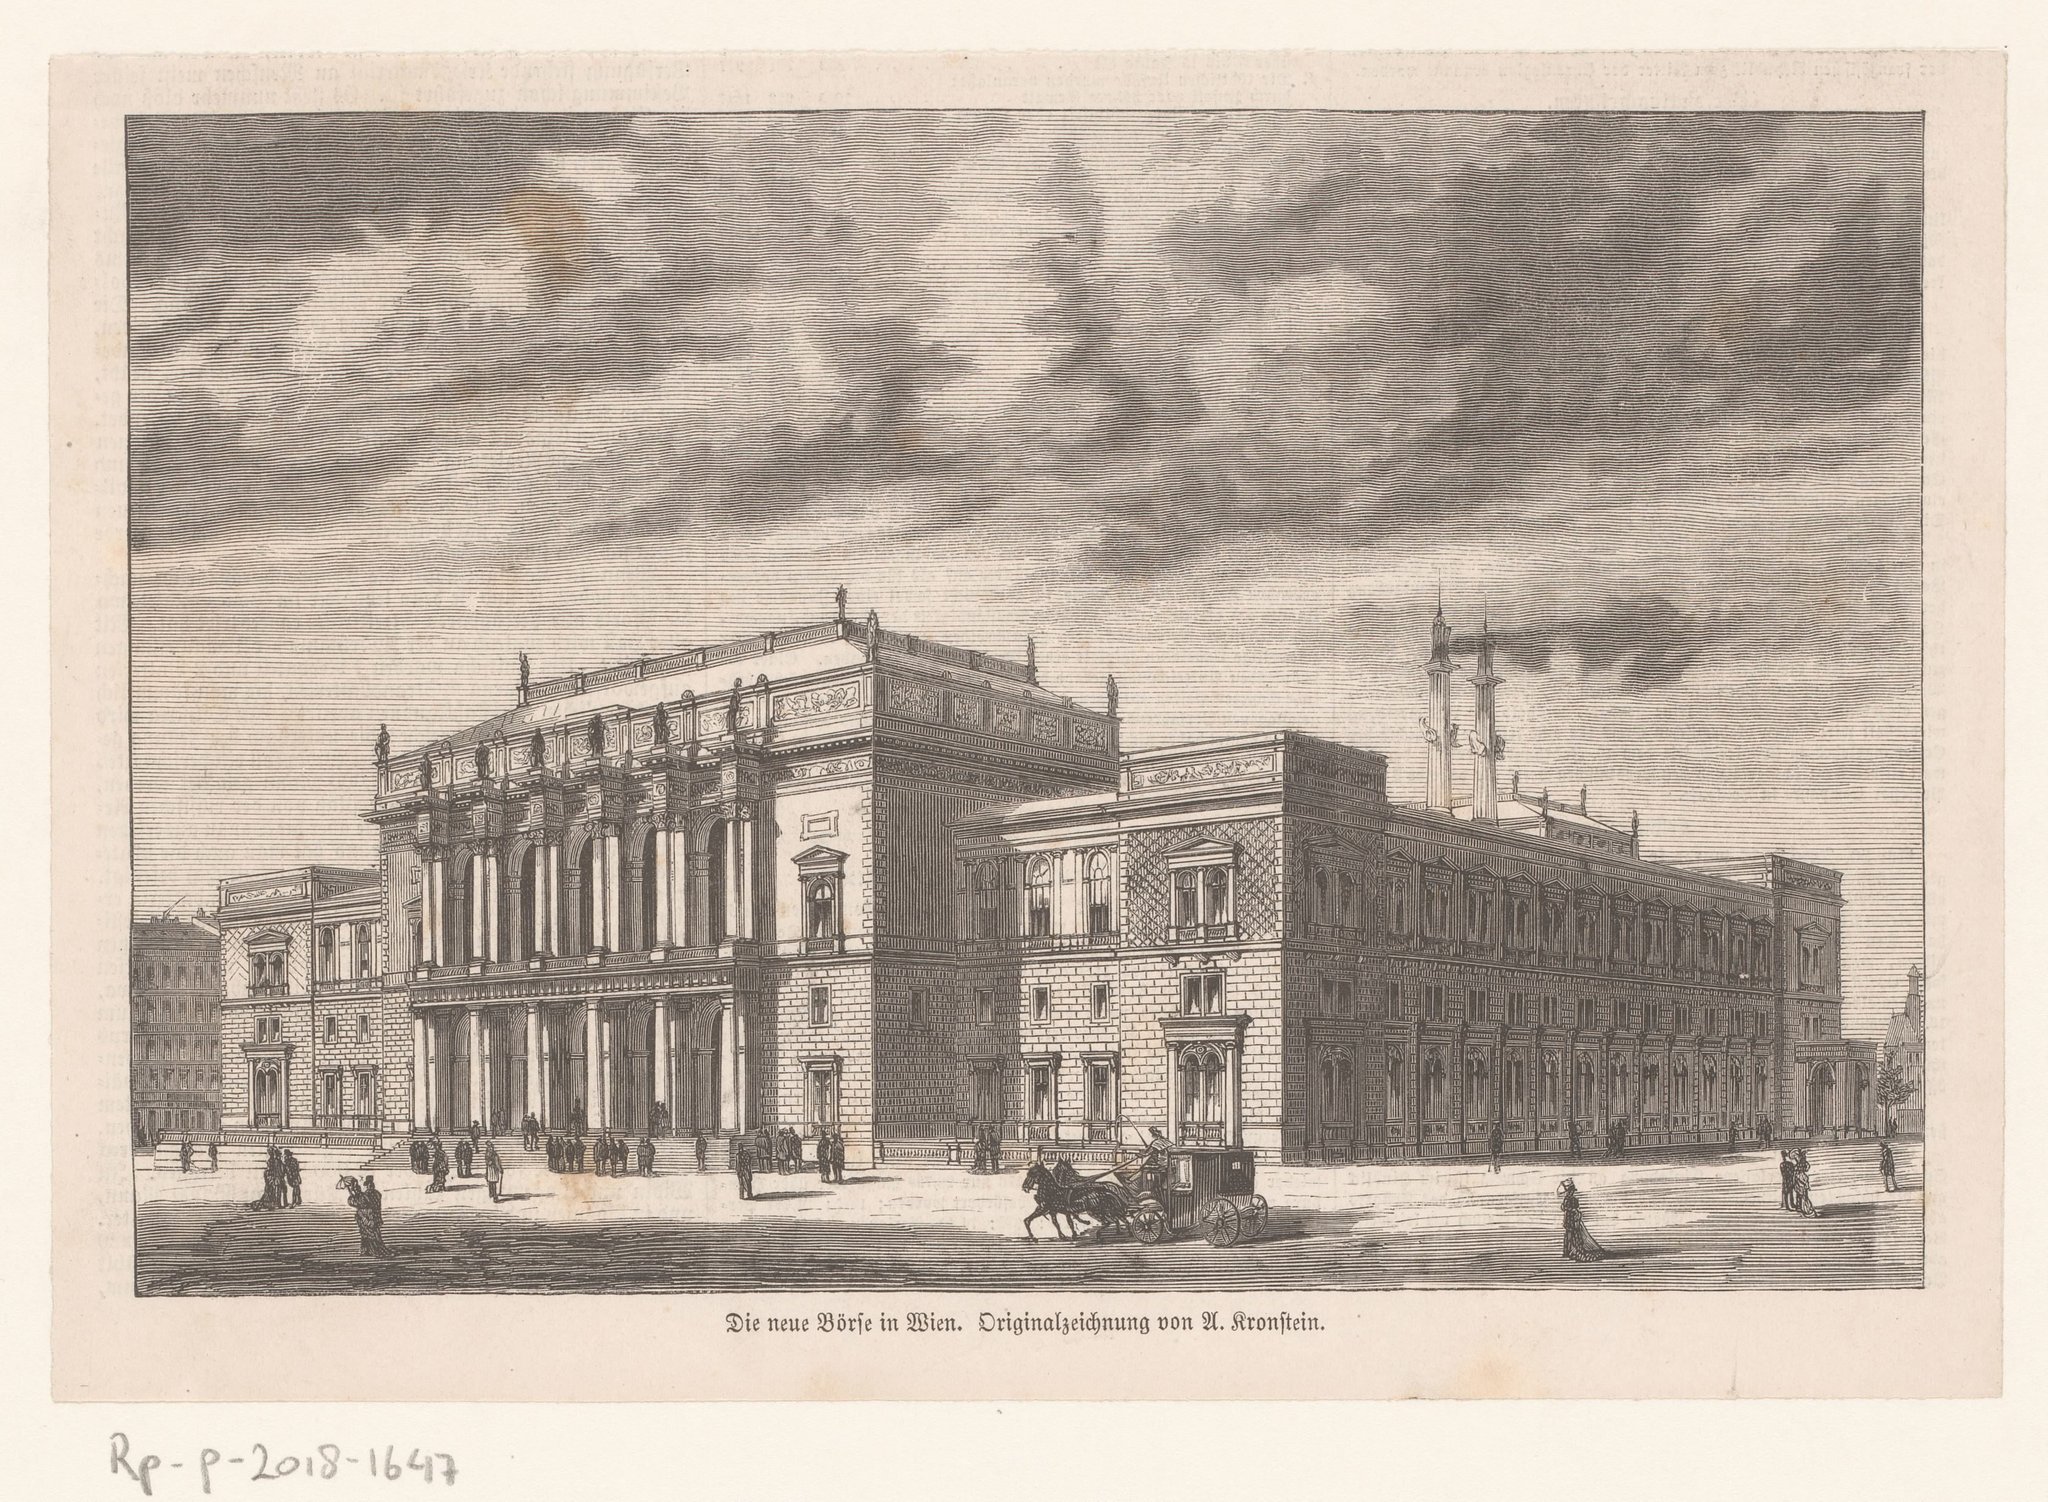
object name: print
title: Gezicht op de beurs, te Wenen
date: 1877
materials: paper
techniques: engraving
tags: exchange, bourse, vienna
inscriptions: collector's mark: Lugt 2228